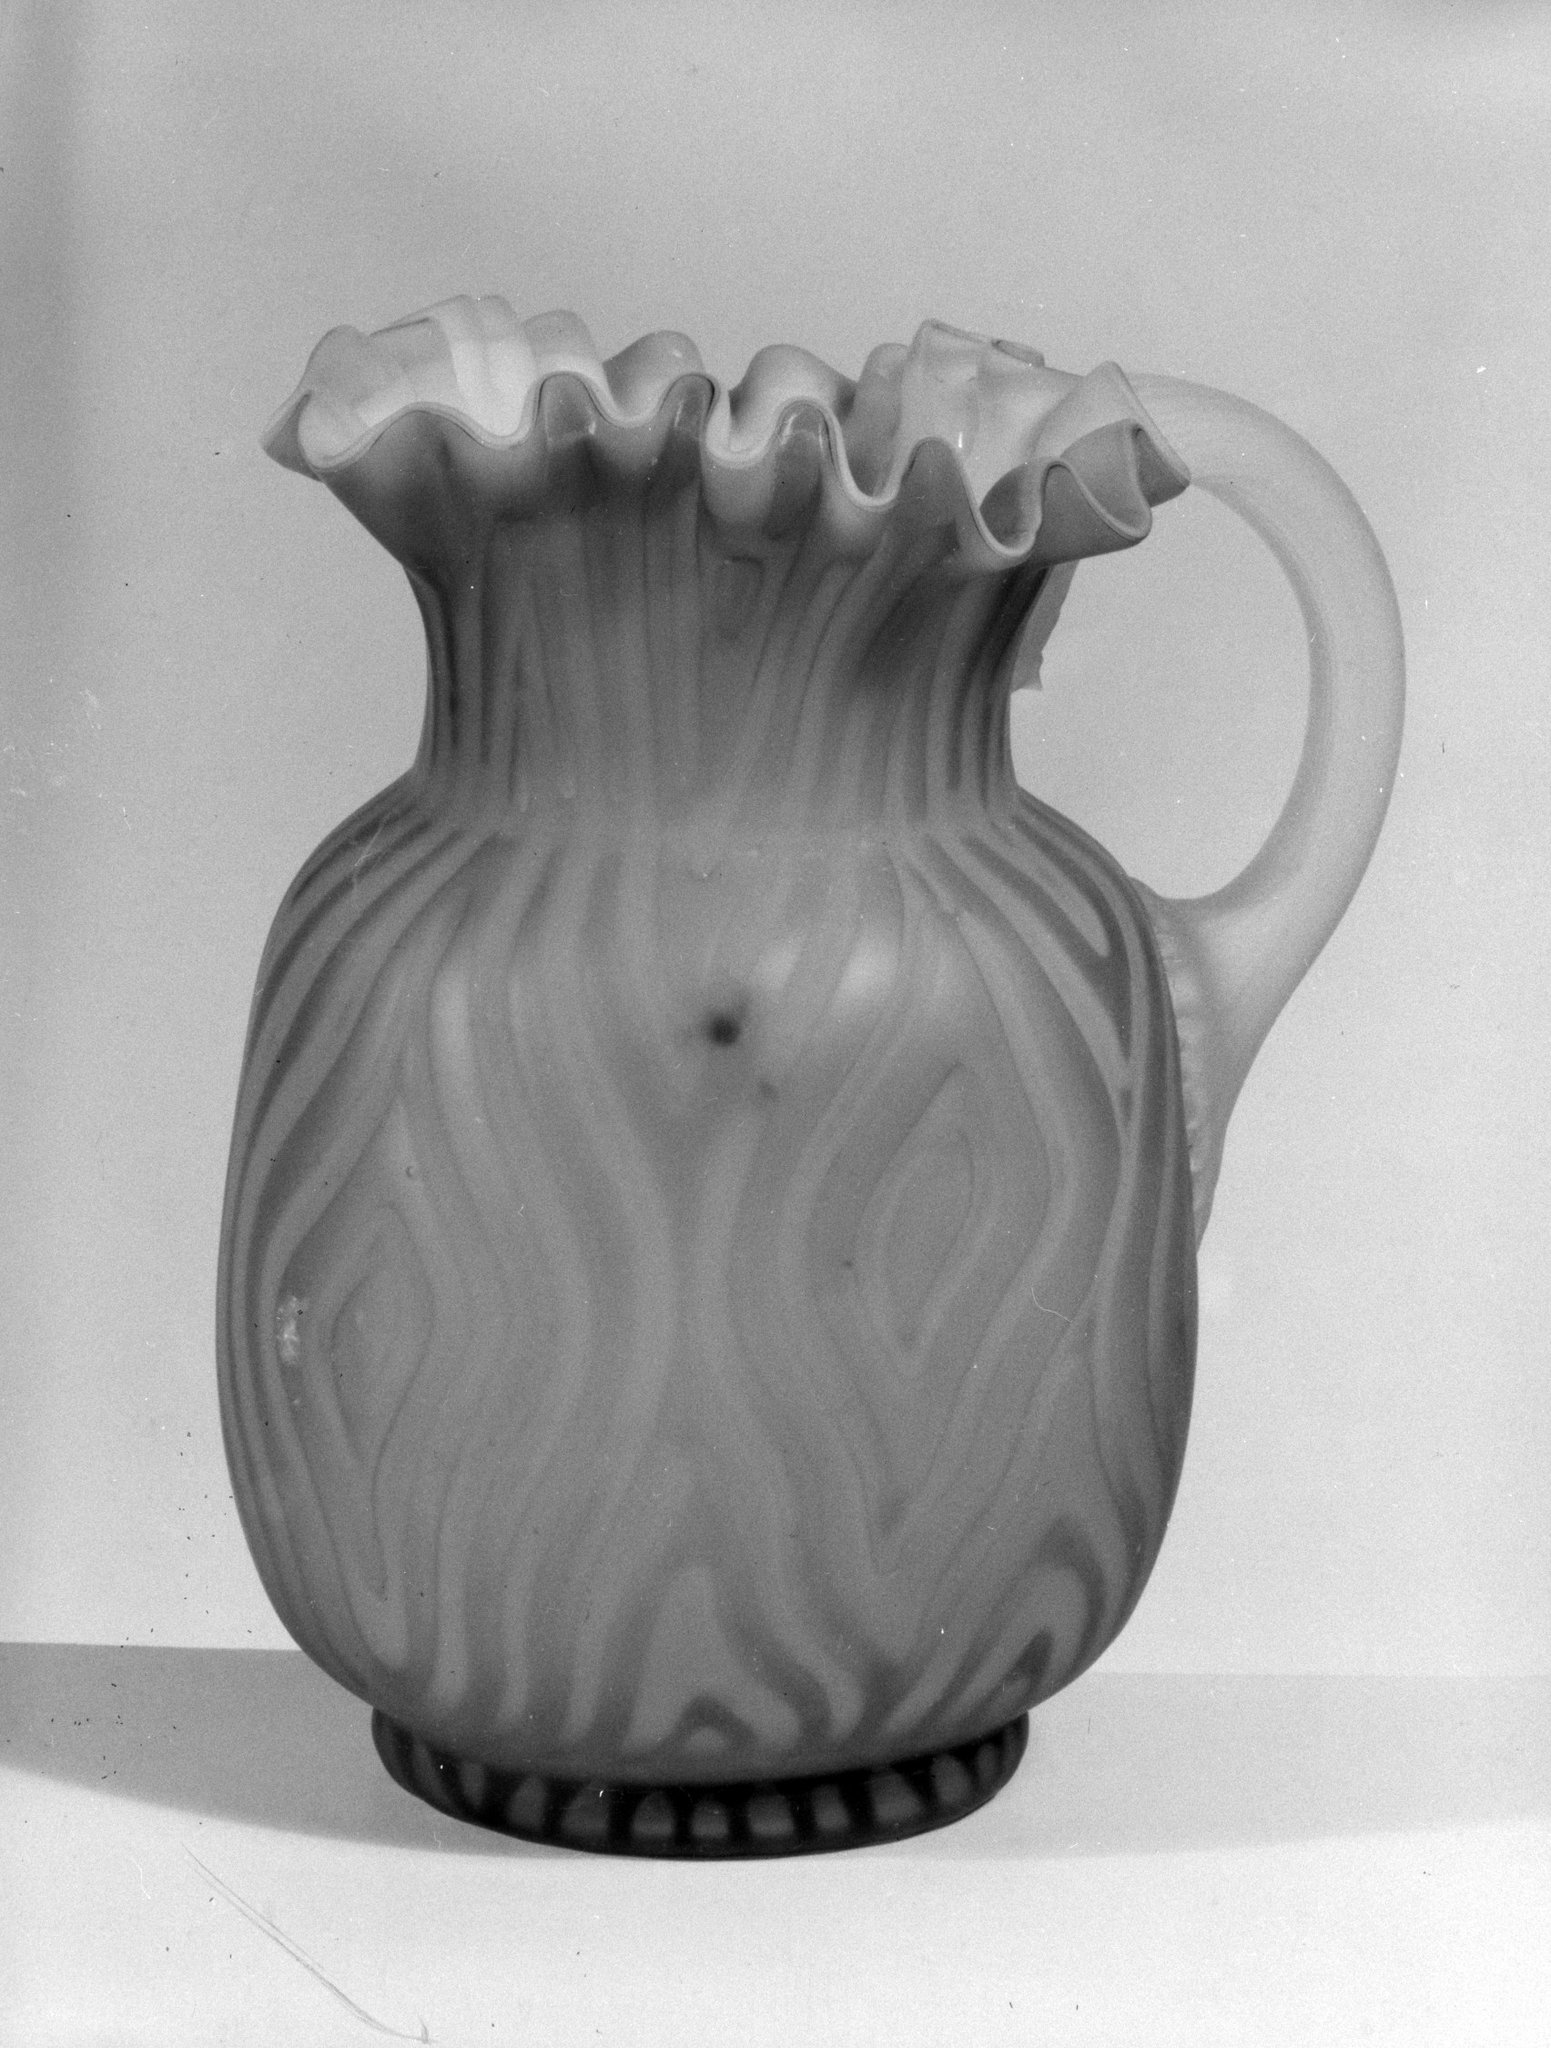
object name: pitcher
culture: american or british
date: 1885-1890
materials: glass, textile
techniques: glassblowing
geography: england